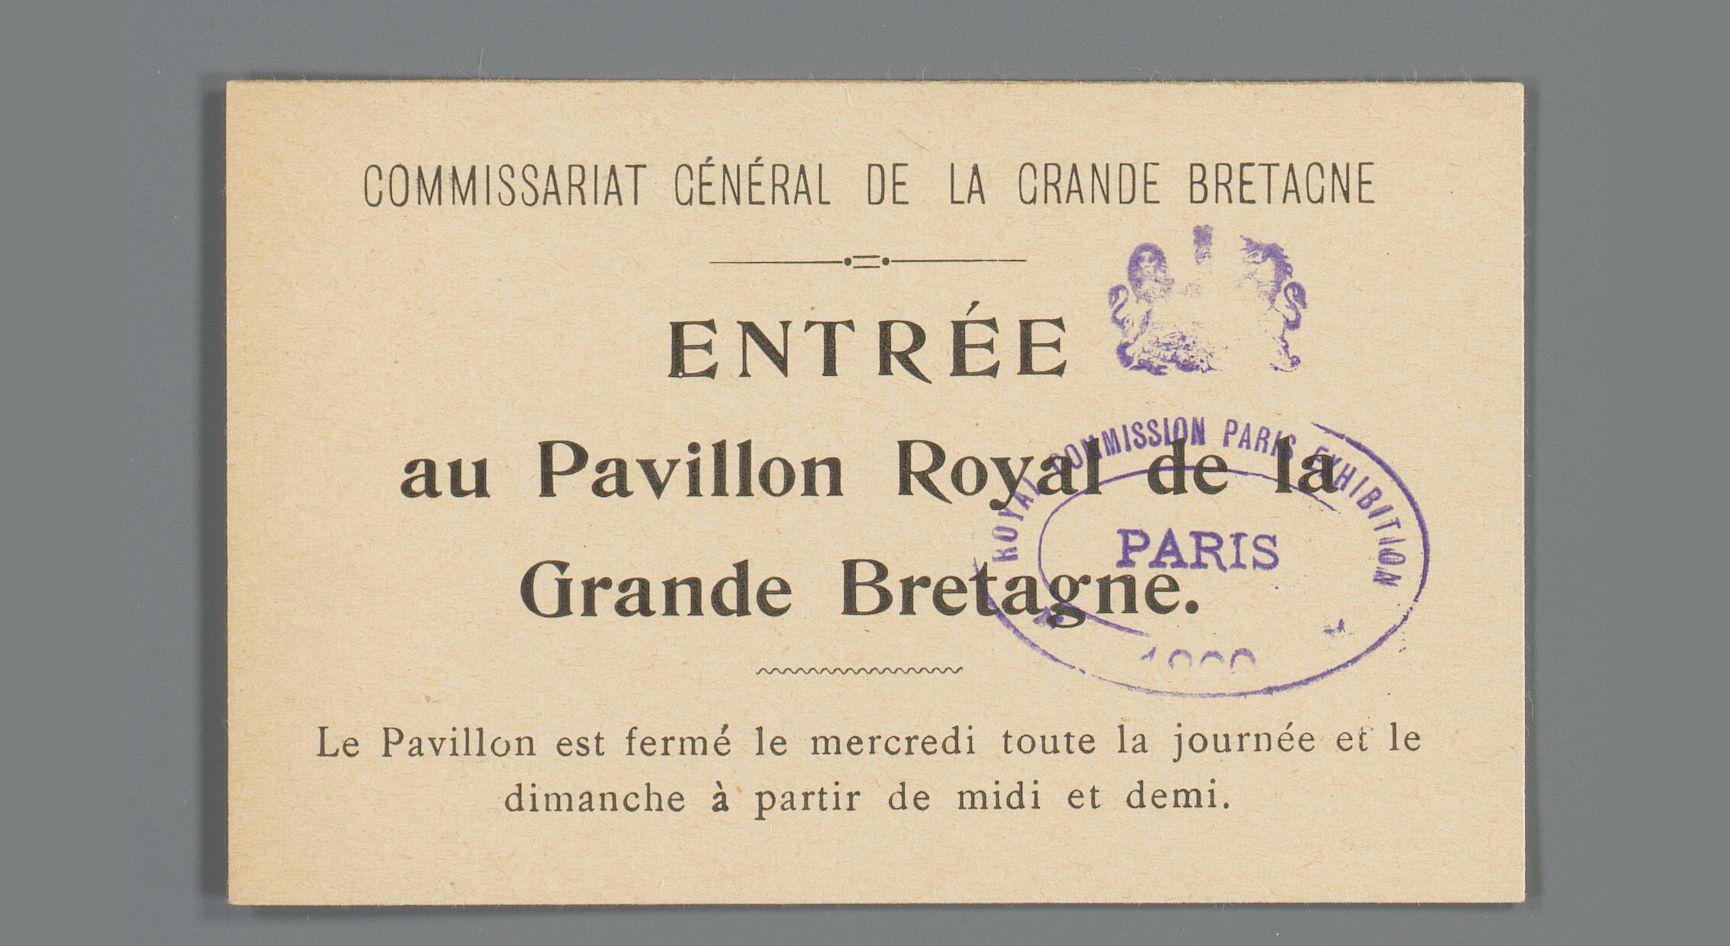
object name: admission ticket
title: Entreebewijs voor het Engelse paviljoen op de Wereldtentoonstelling 1900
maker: Anonymous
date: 1900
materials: paper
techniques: printing block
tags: printed matter, paris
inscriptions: stamp: ‘[Wapen van het Verenigd Koninkrijk] Royal Commission Paris Exhibition 1900’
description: Kaart met de tekst: 'Commissariat général de la Grande Bretagne. Entrée au Pavillon Royal de la Grande Bretagne. Le Pavillon est fermé le mercredi toute la journée et le dimanche à partir de midi et demi'.